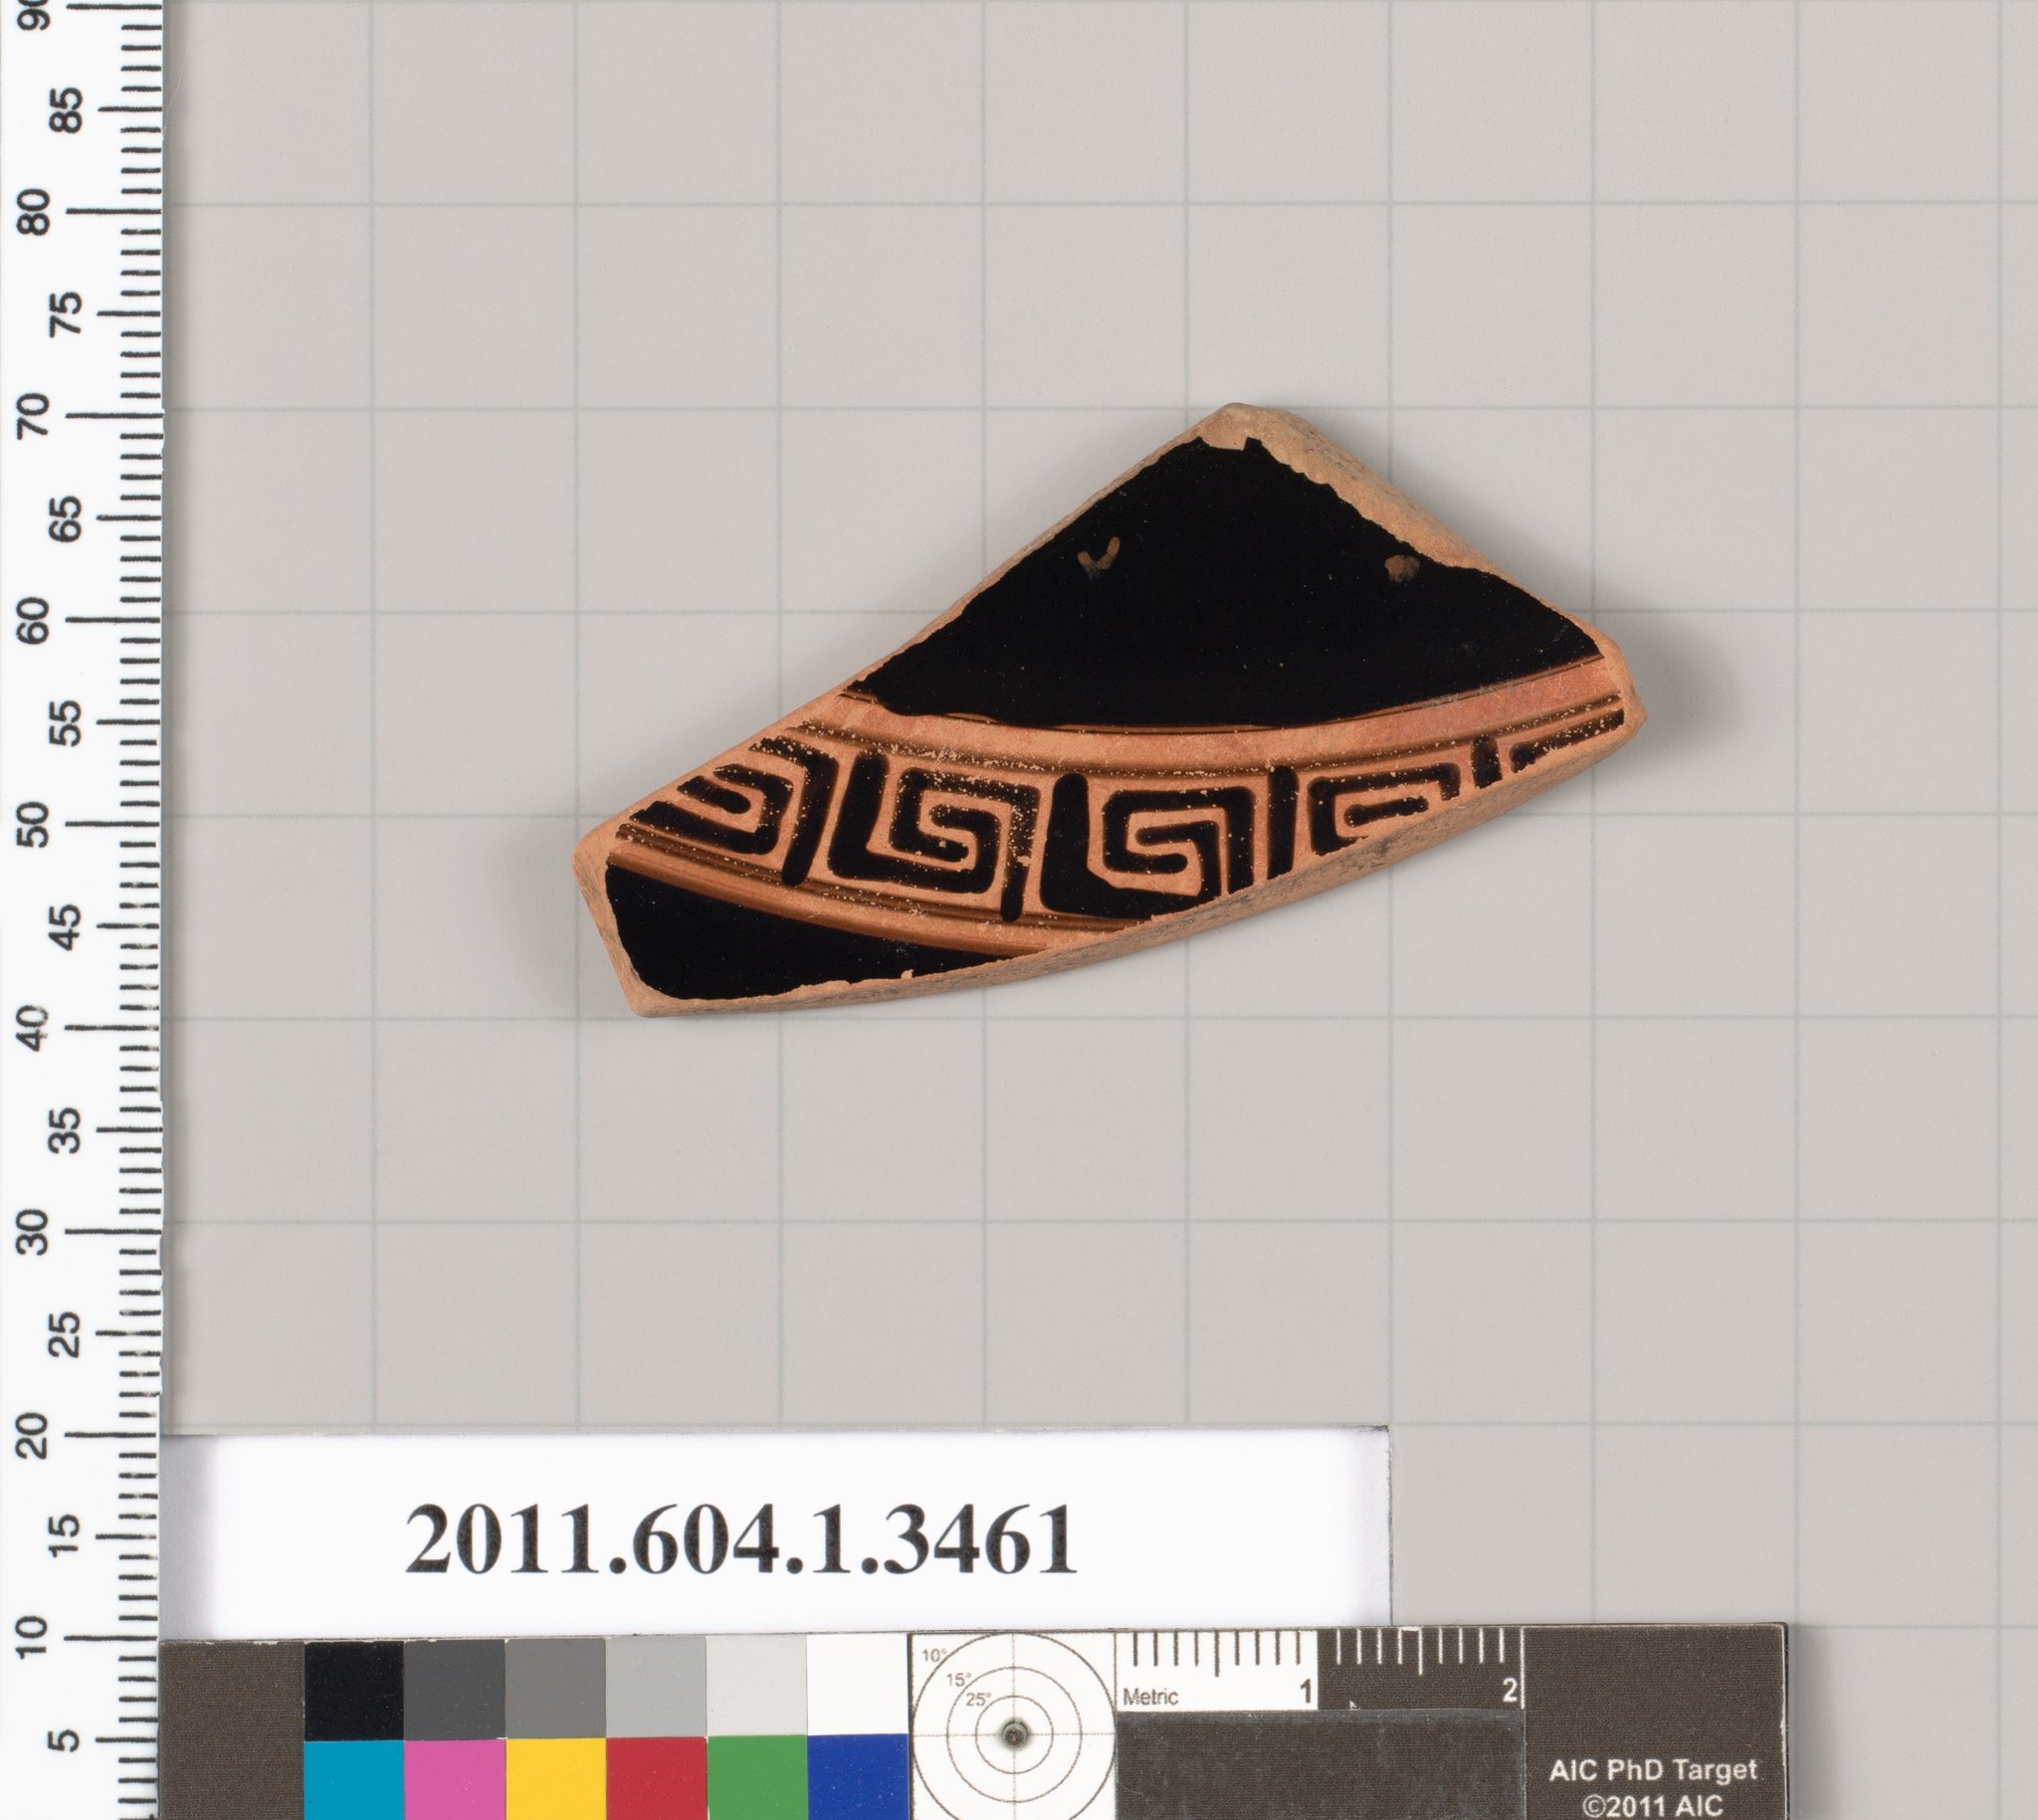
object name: kylix fragment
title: Terracotta fragment of a kylix (drinking cup)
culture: greek, attic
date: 500-476 BCE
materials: terracotta